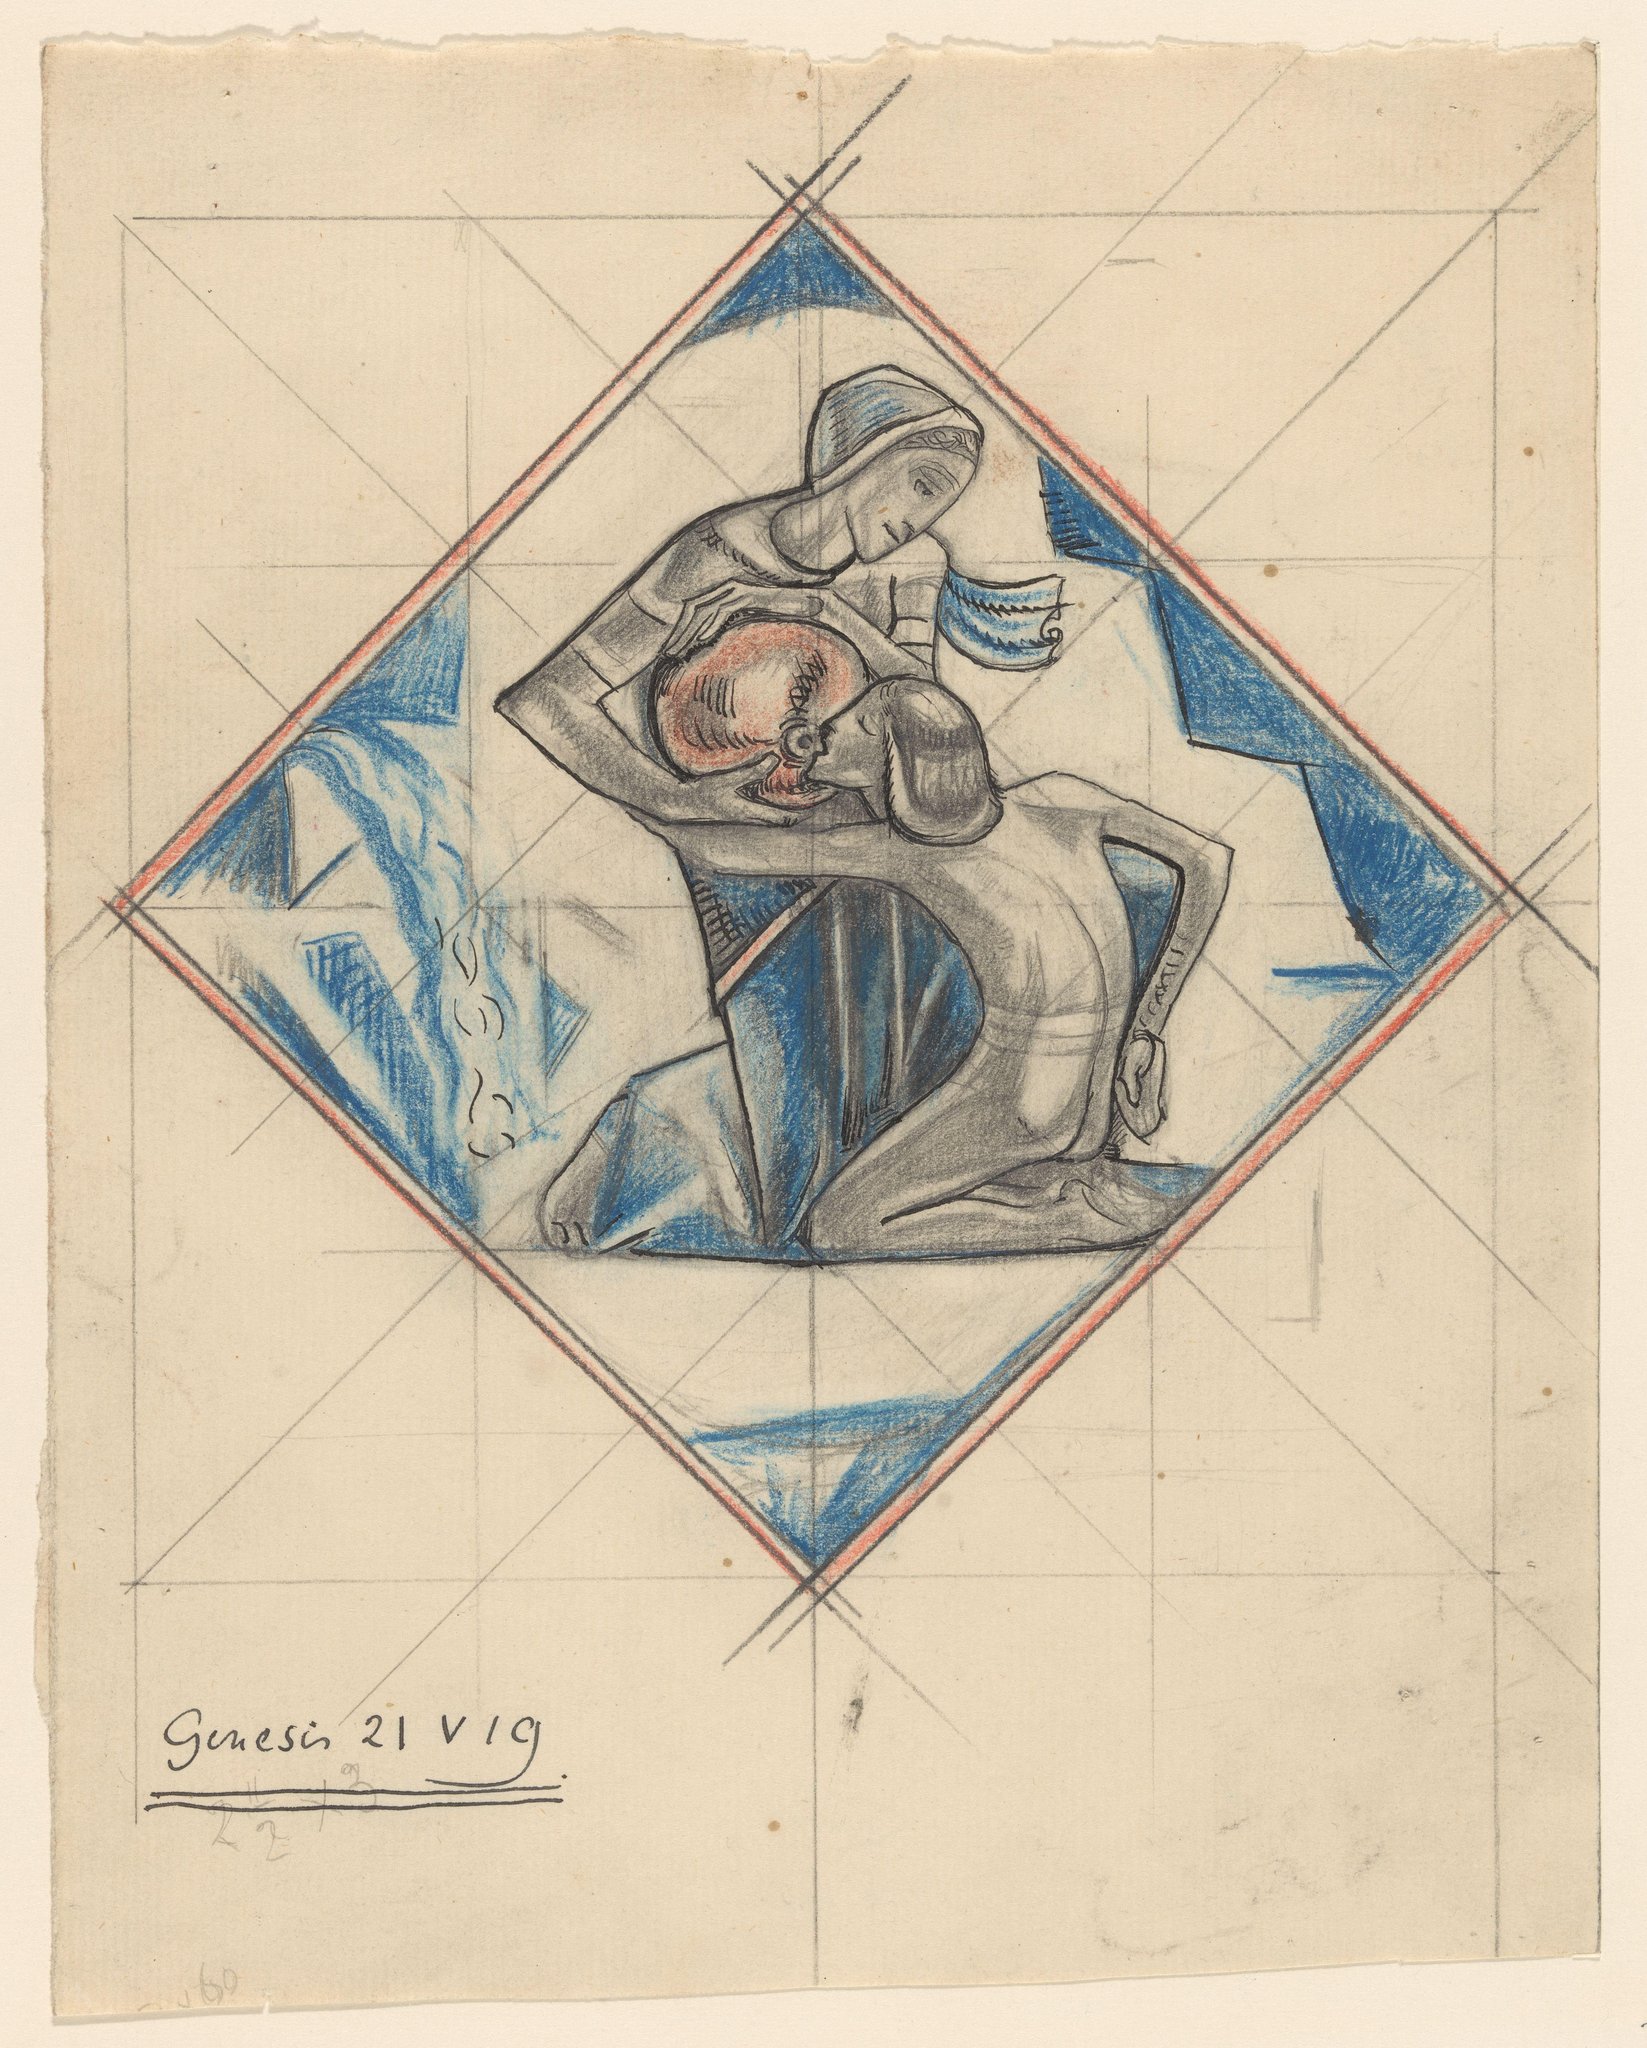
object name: drawing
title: Hagar laaft haar zoon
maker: richard nicolaüs roland holst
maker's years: 1868-1938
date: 1878-1938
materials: ink, paper, pencil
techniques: pen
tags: an angel appears and reveals a well of water to hagar (+ variant)